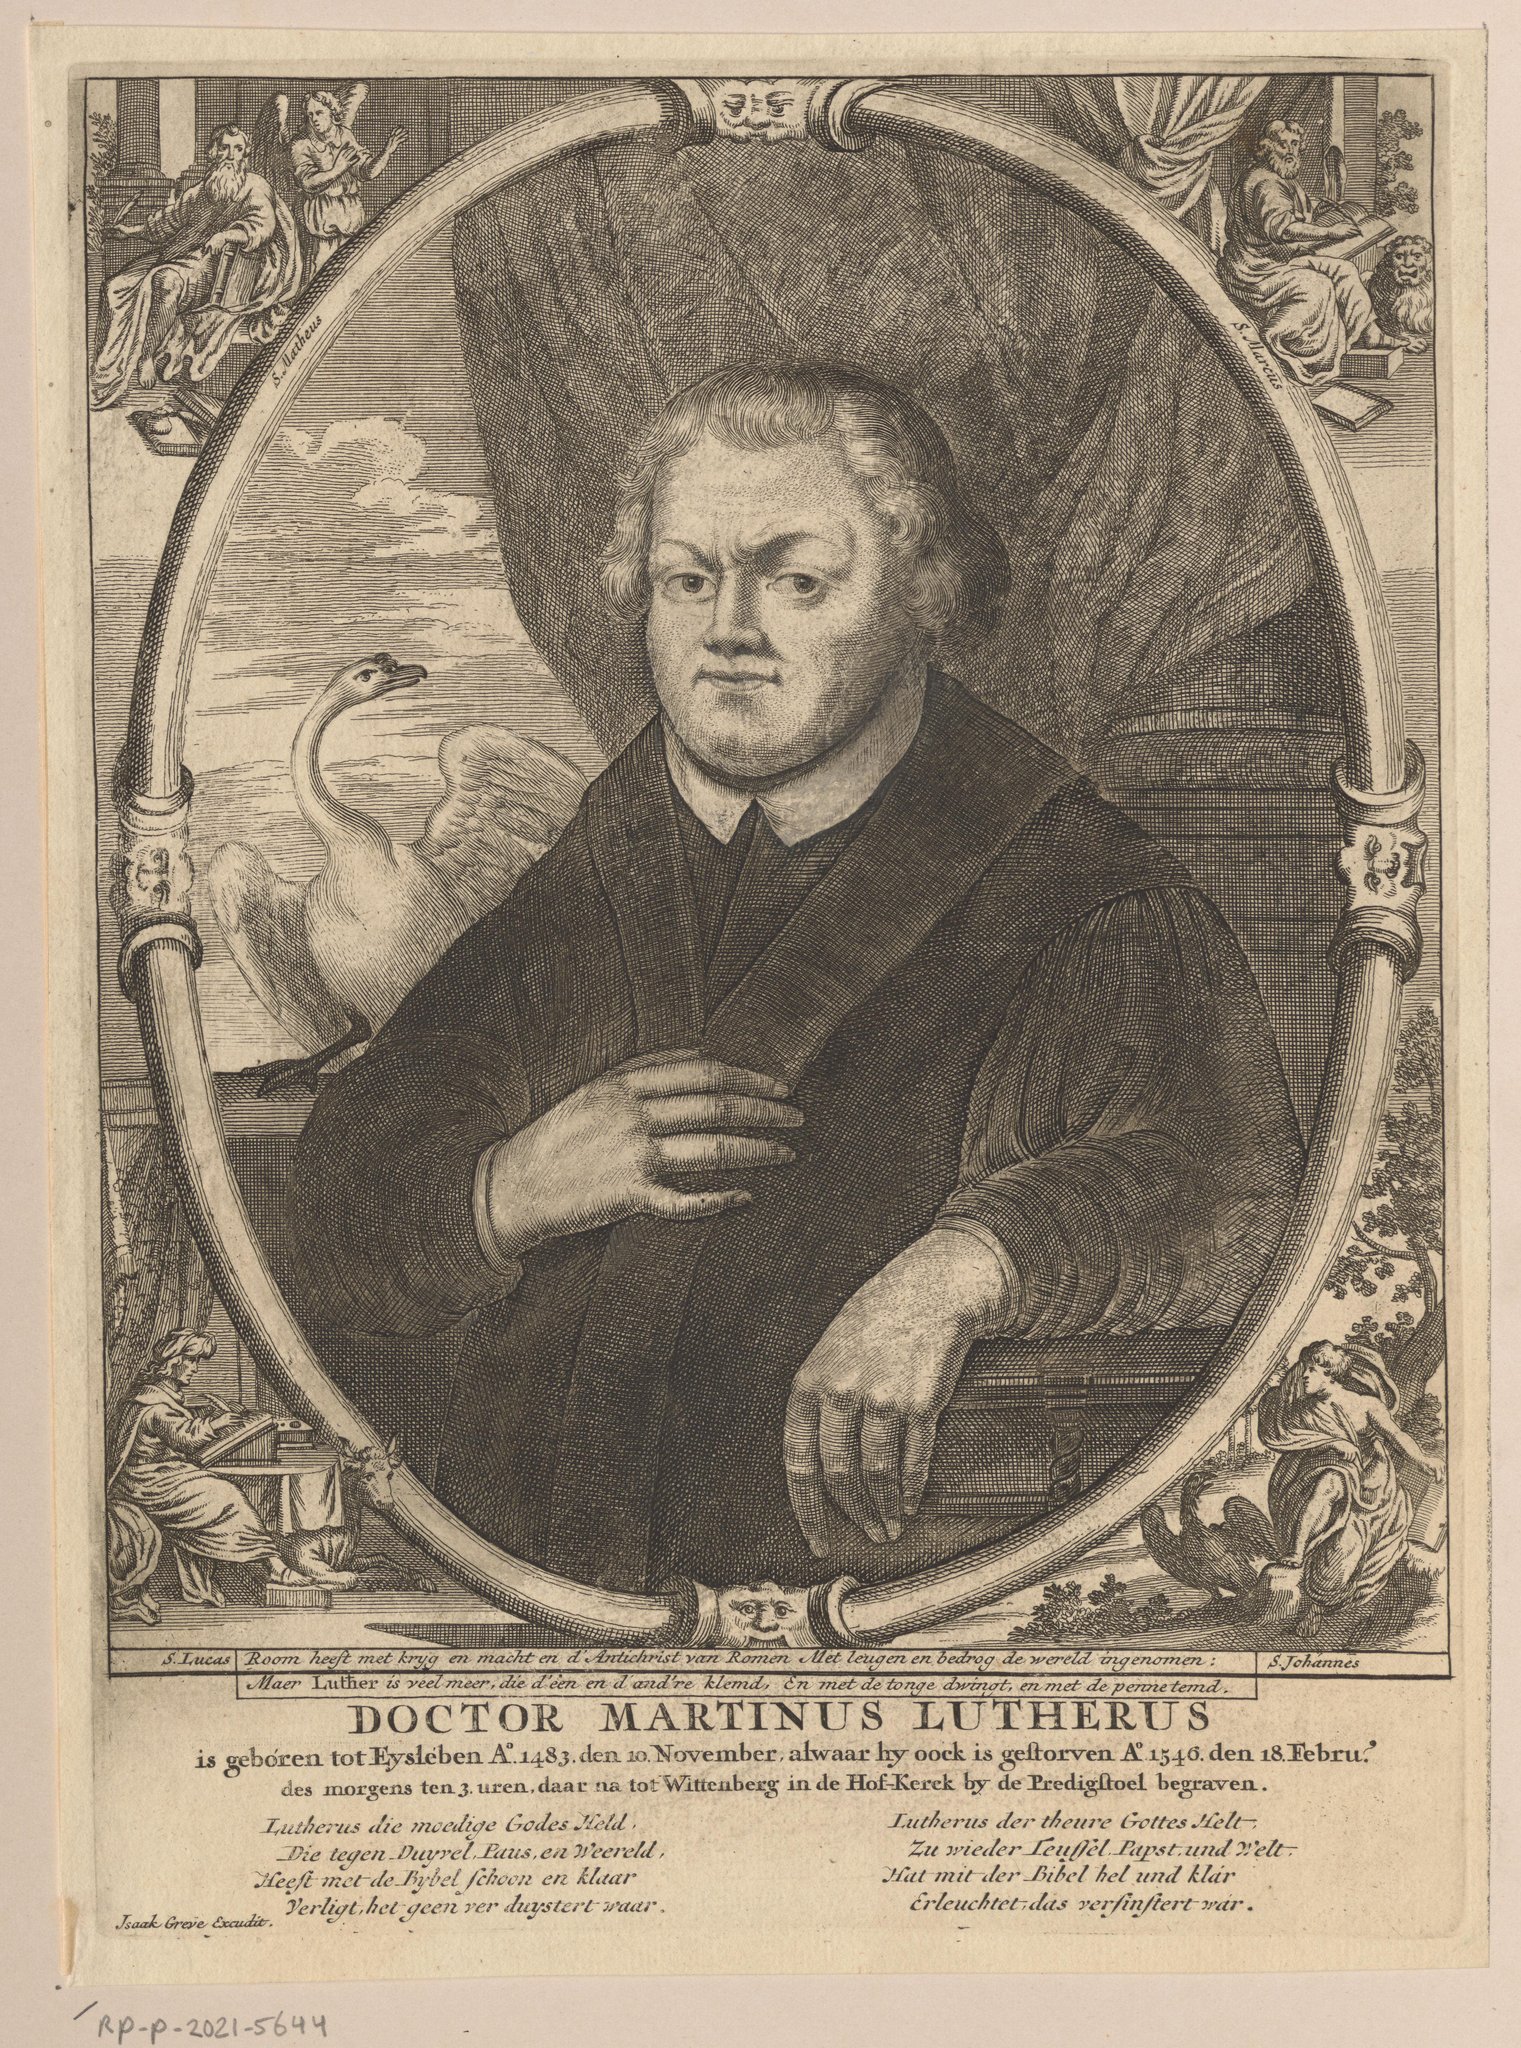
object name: print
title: Portret van Martin Luther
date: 1718-1757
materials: paper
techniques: engraving, etching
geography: northern netherlands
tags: priest, martin luther, theologian, the four evangelists together (author portraits), water-birds: swan, ornament ~ medallion, historical persons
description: Portret in medaillon met zwaan. Rondom het portret de vier evangelisten. Met onderschrift in het Nederlands en vierregelig vers in het Nederlands en Duits onder de prent.